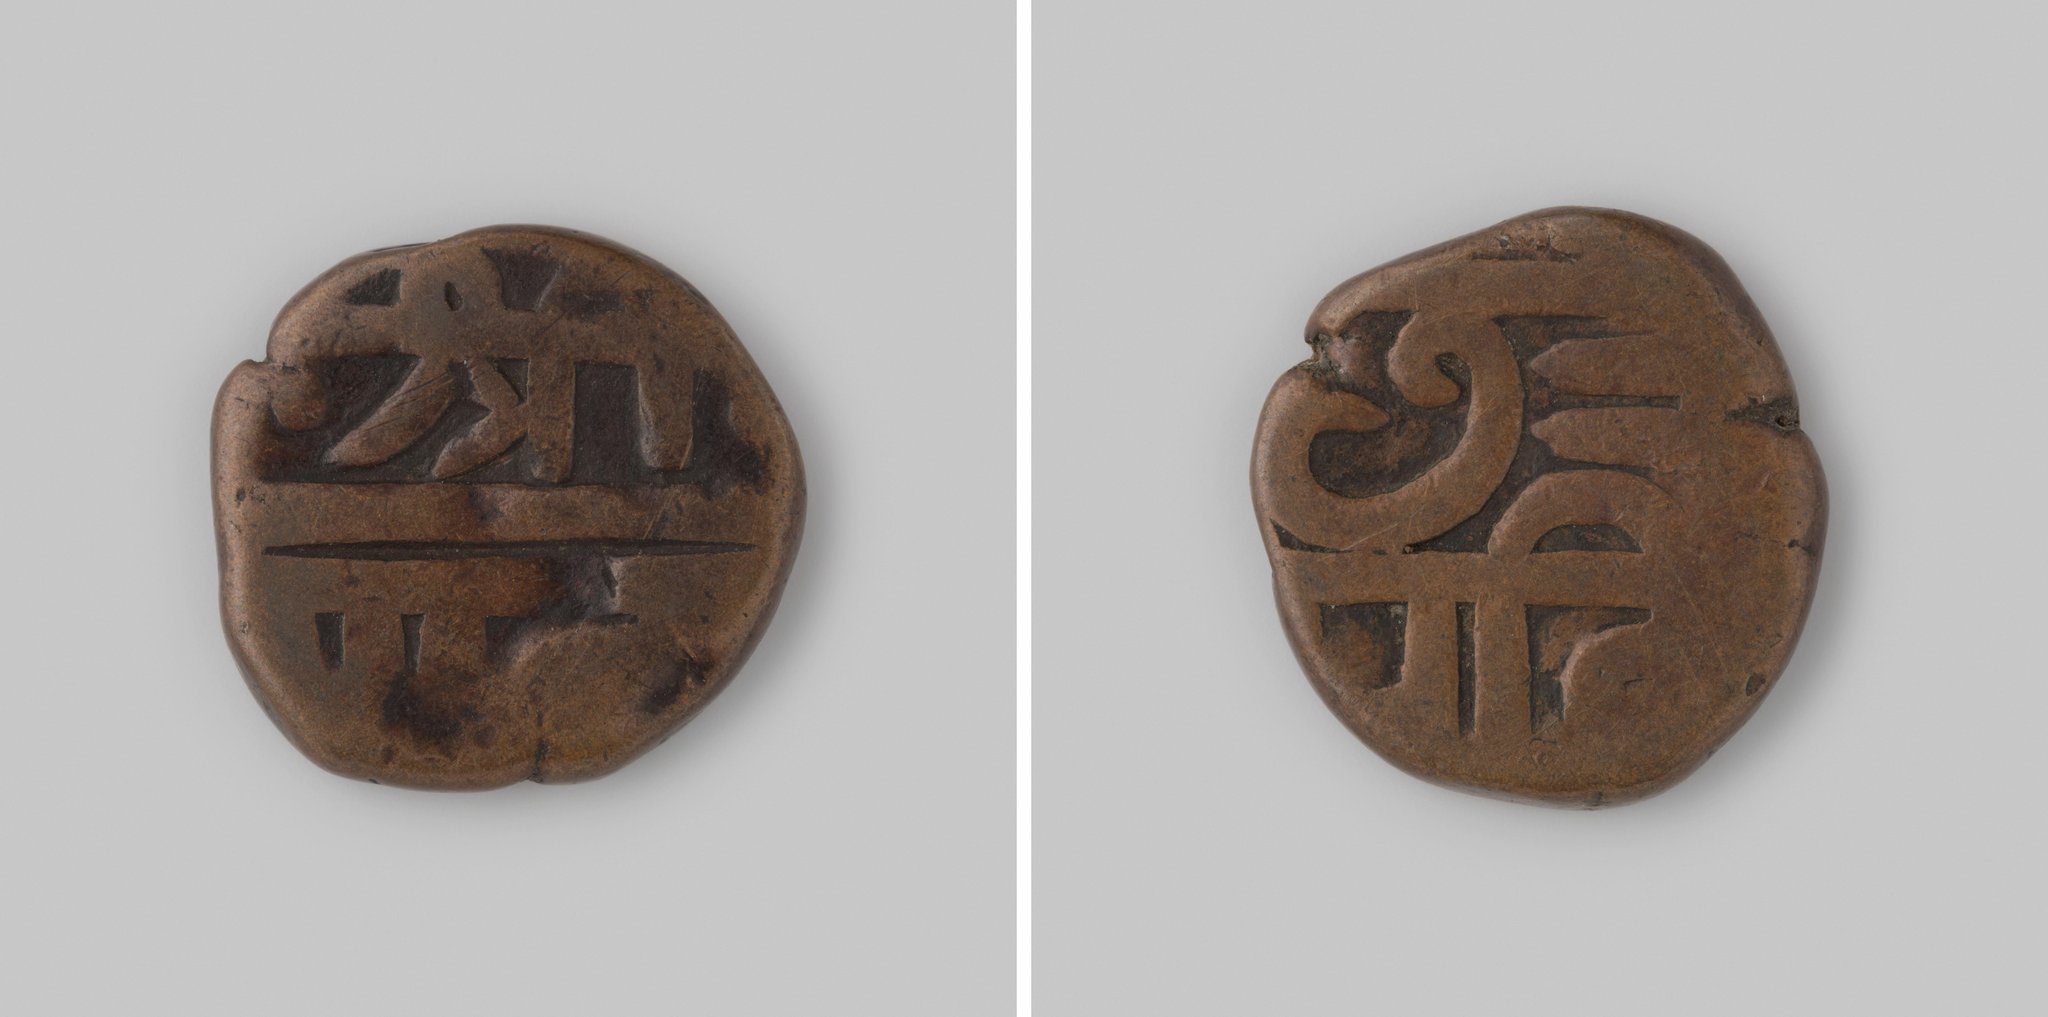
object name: coin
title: Paisa uit India van de marathas van Tanjore, 1650-1850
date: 1650-1850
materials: copper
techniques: striking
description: Koperen munt. Voorzijde: in twee regels opschrift. Keerzijde: in twee regels opschrift in Nagari-tekens.